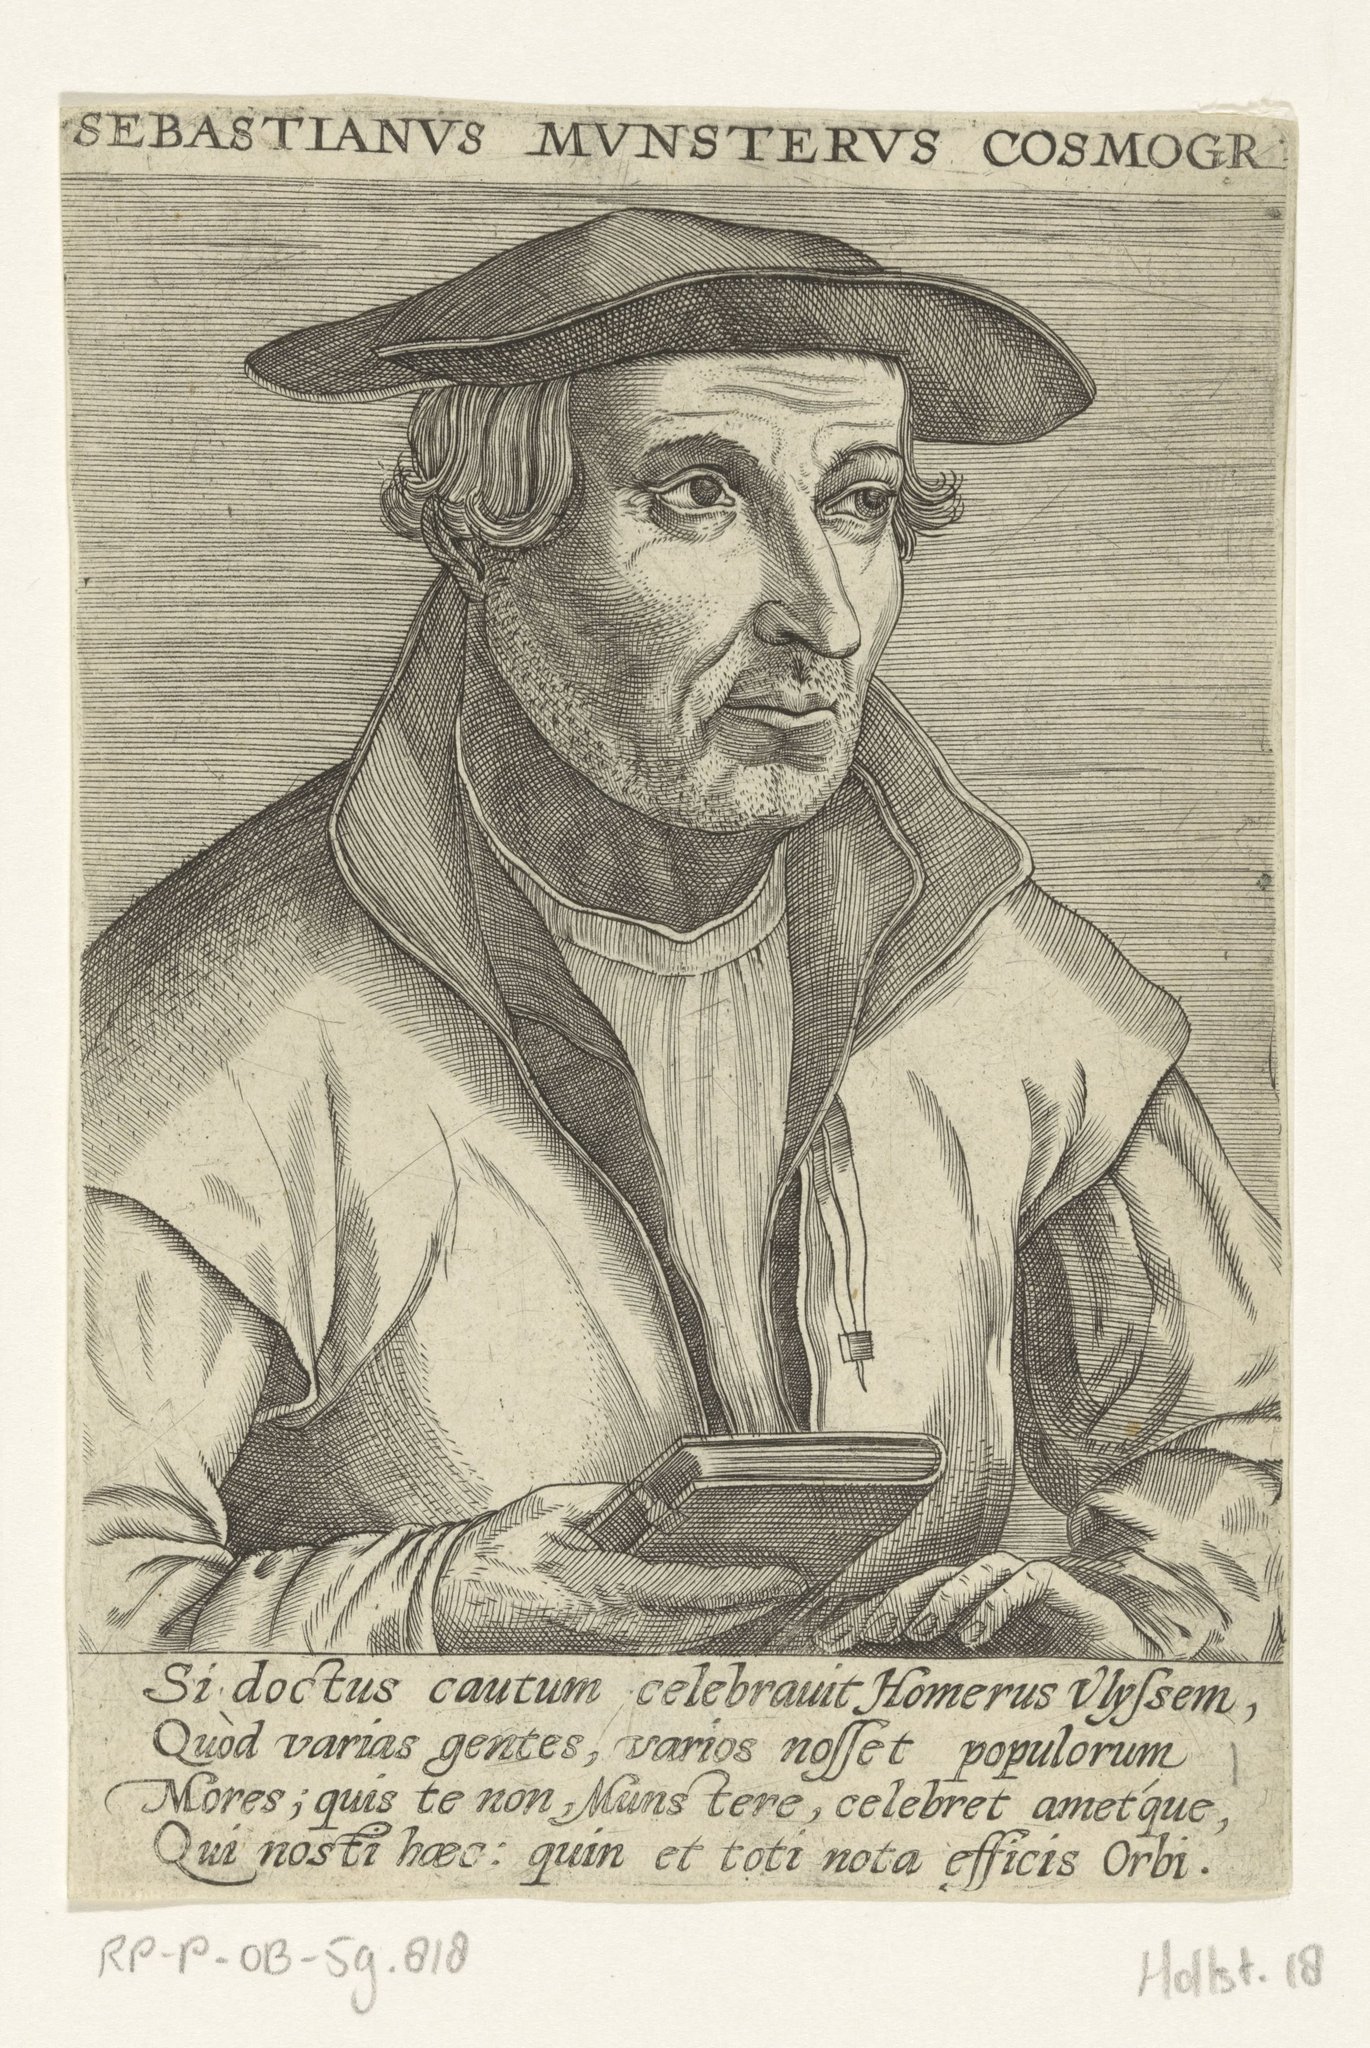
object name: print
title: Portret van Sebastian Münster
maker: jan van stalburch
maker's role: print maker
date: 1555-1562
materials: paper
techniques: engraving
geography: leuven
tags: ingelheim, bazel, humanist, sebastian münster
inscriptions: collector's mark: Lugt 2228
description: Portret van Sebastian Münster, kosmograaf, humanist en hebraïcus, met een boek in zijn hand. Onderaan in de marge een vierregelige tekst in het Latijn.